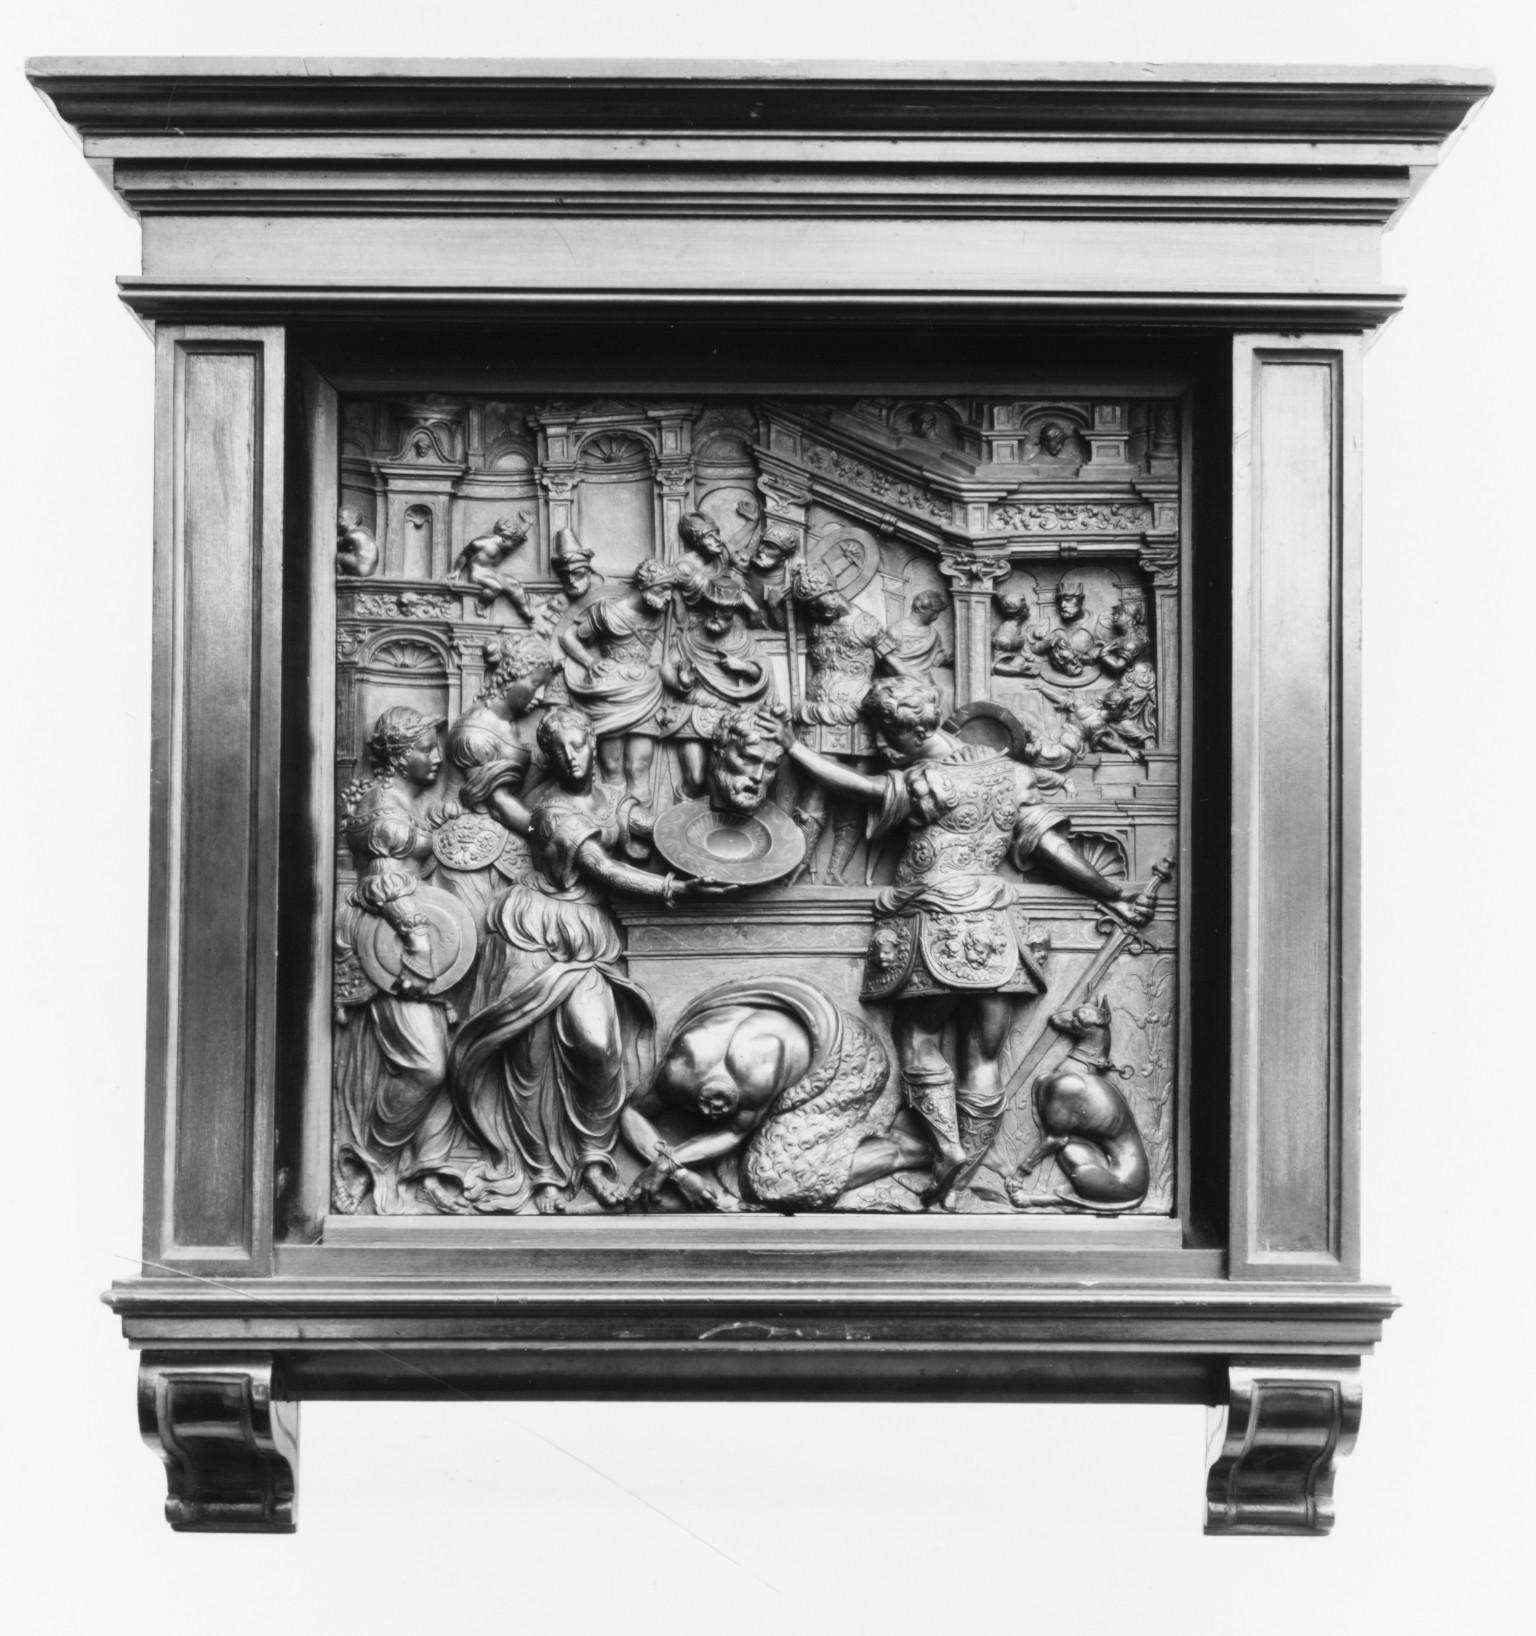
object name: relief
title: The Beheading of Saint John the Baptist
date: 1534-1566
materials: gilt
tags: men,women,dogs,saint john the baptist,salome